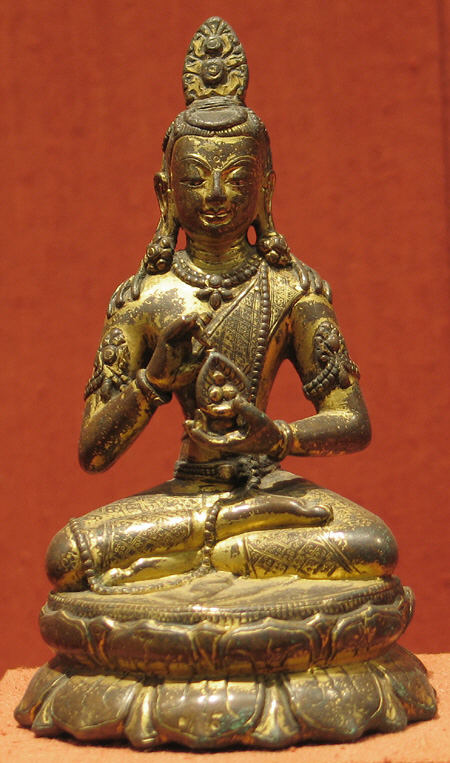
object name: figurine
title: Bodhisattva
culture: nepali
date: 1101-1200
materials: copper alloy, gilt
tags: buddhism,bodhisattvas